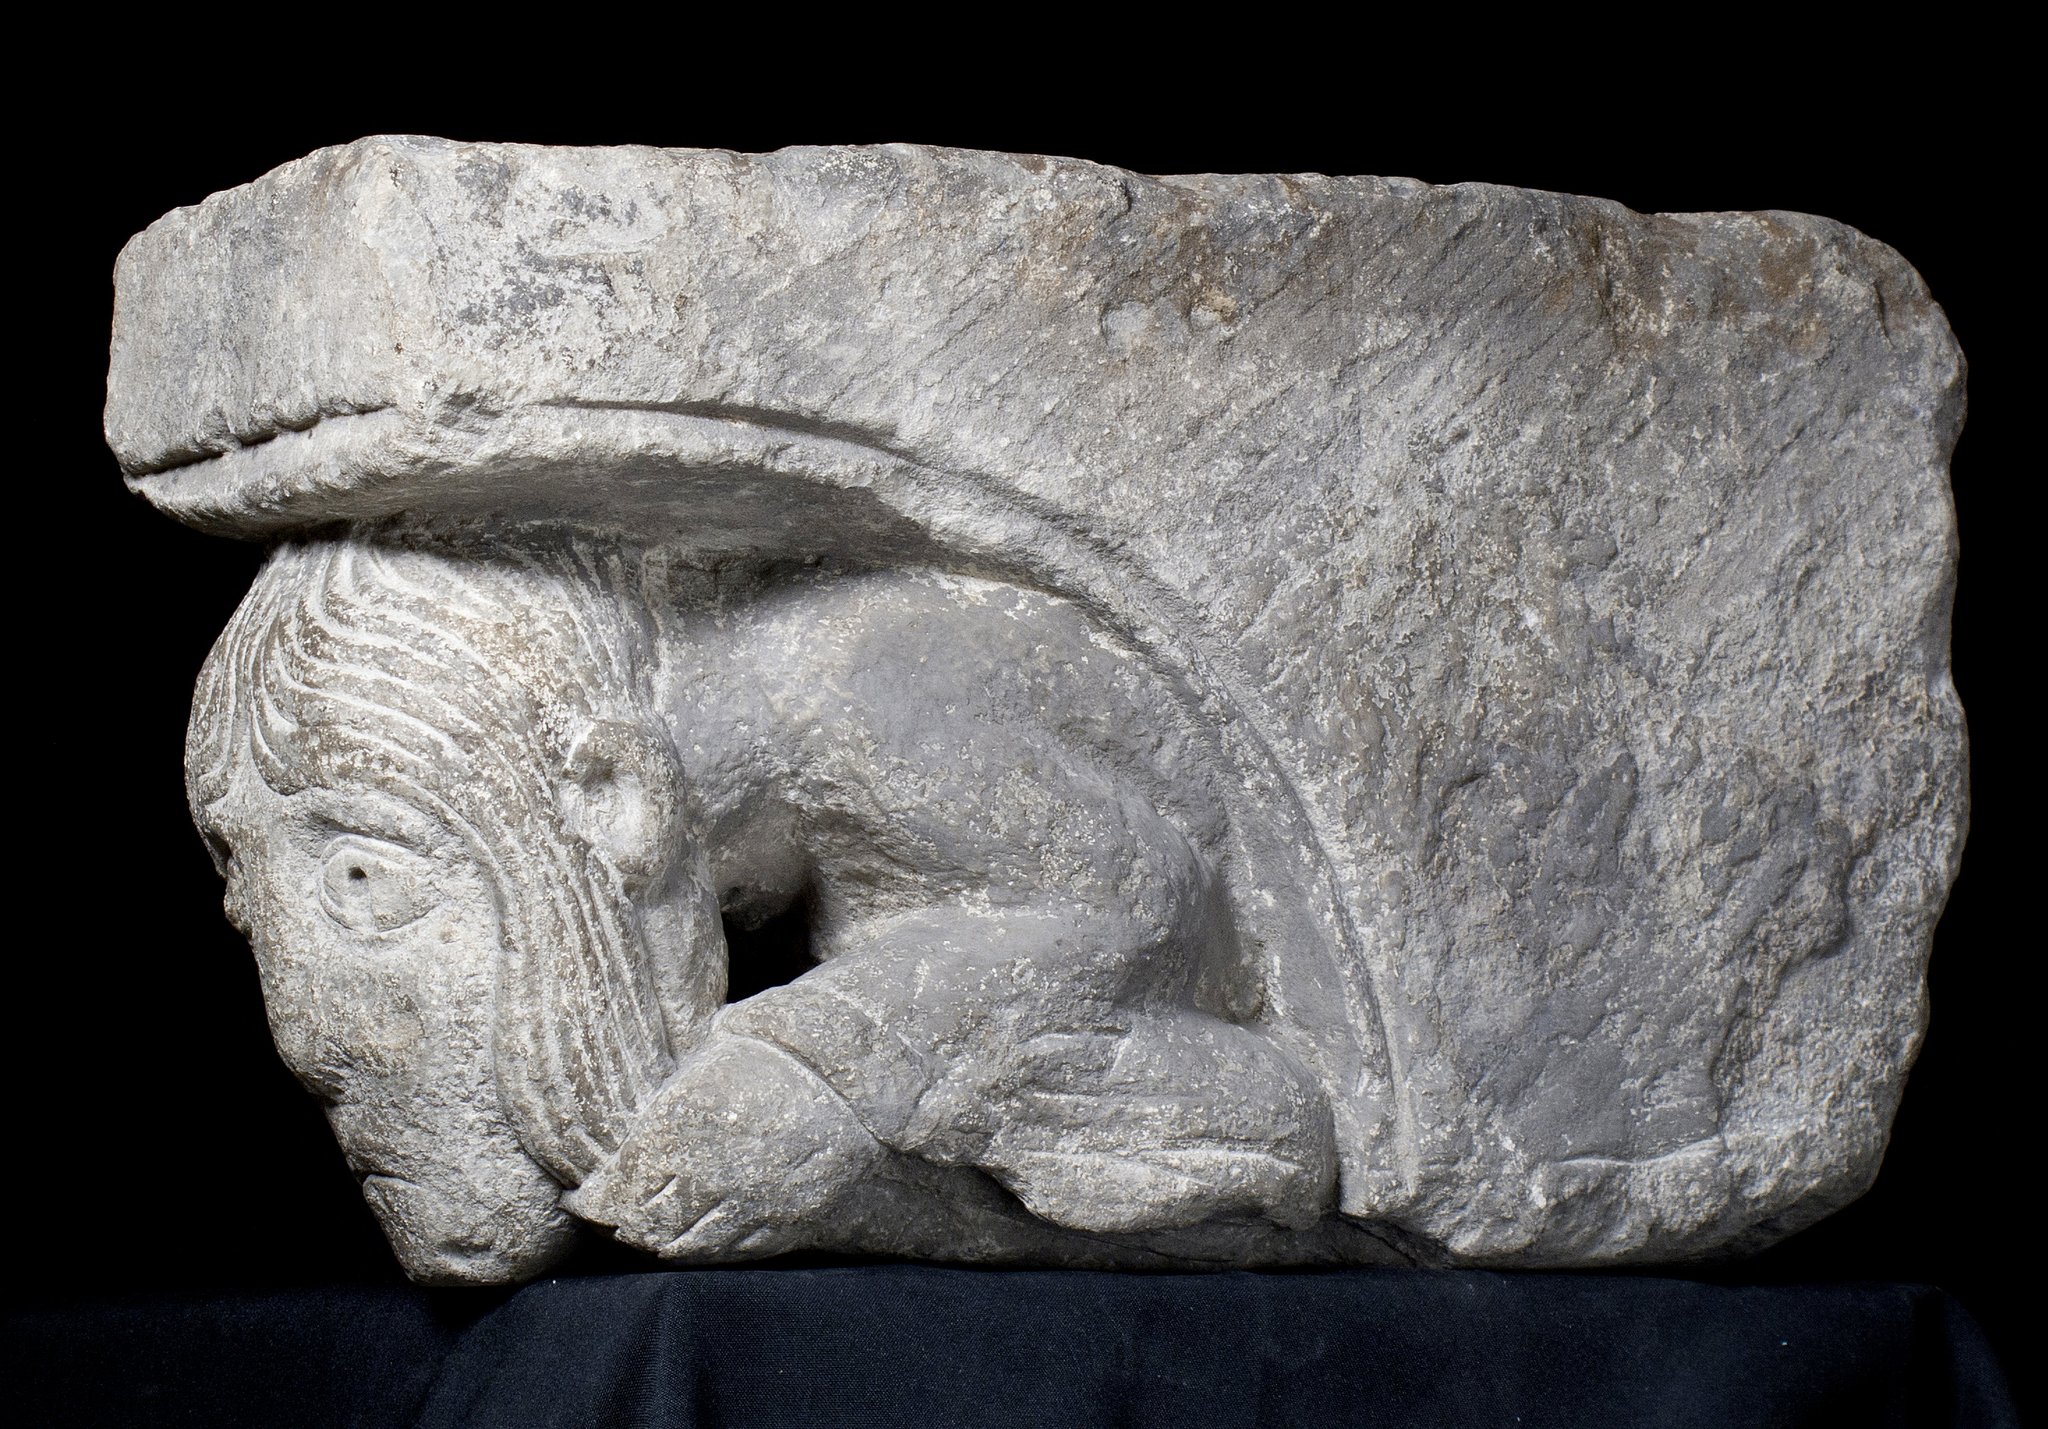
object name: corbel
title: Corbel with Crouching Woman Clutching her Long Hair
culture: french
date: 1101-1200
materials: limestone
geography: france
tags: women